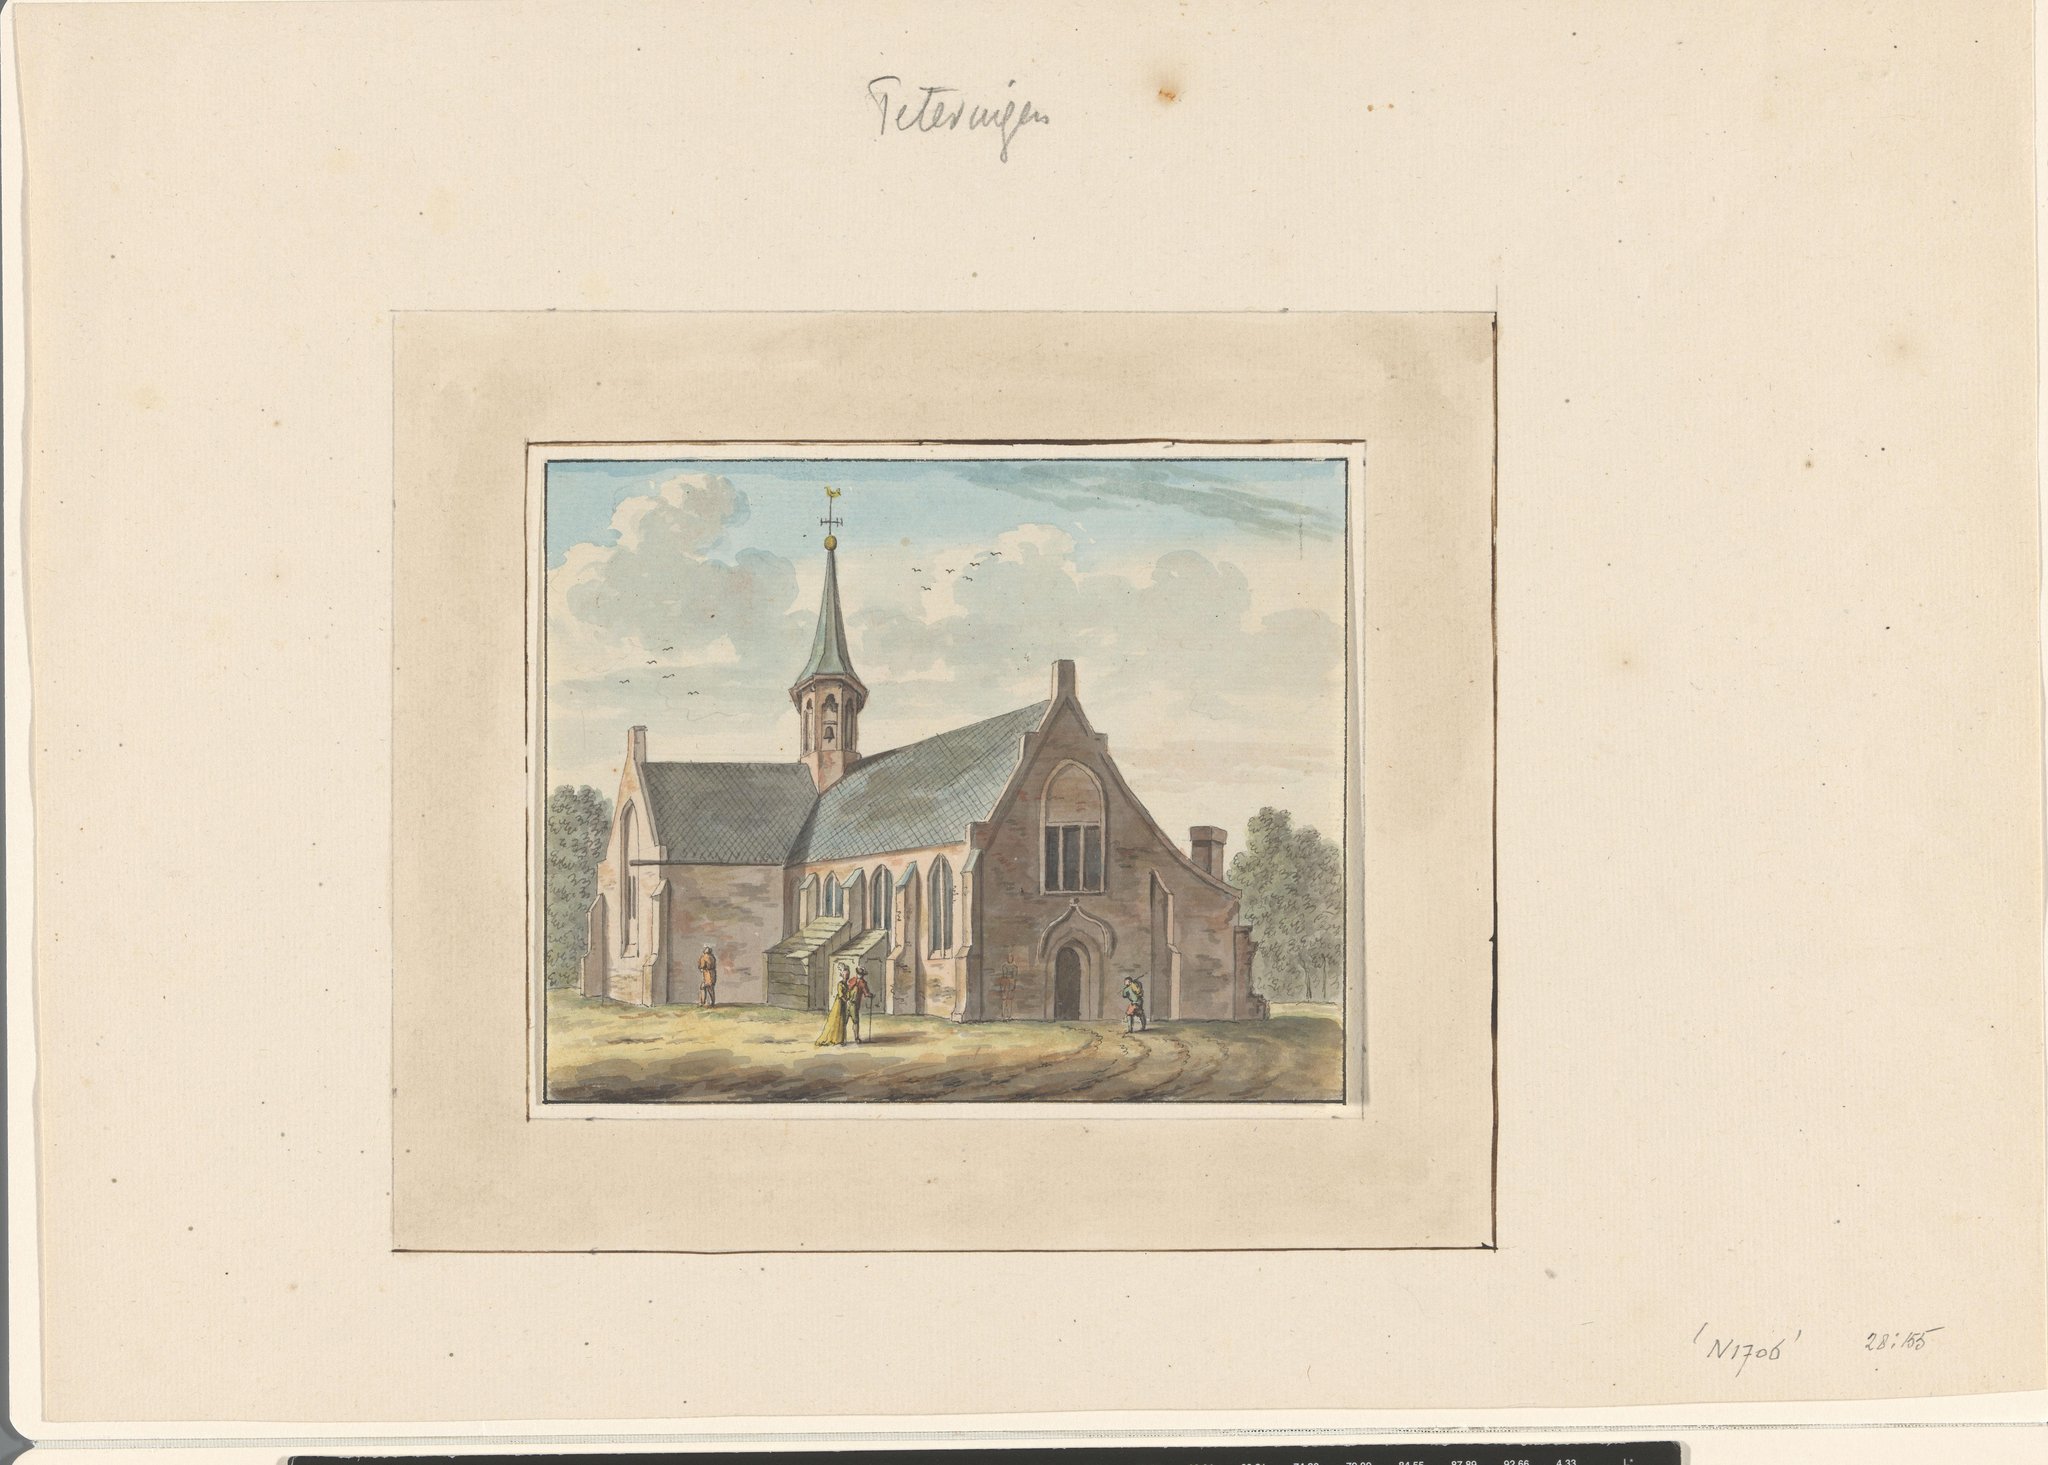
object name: watercolor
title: De kerk van Teteringen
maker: Anonymous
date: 1700-1800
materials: ink, paper, pencil, watercolor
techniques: brush, pen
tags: church (exterior)